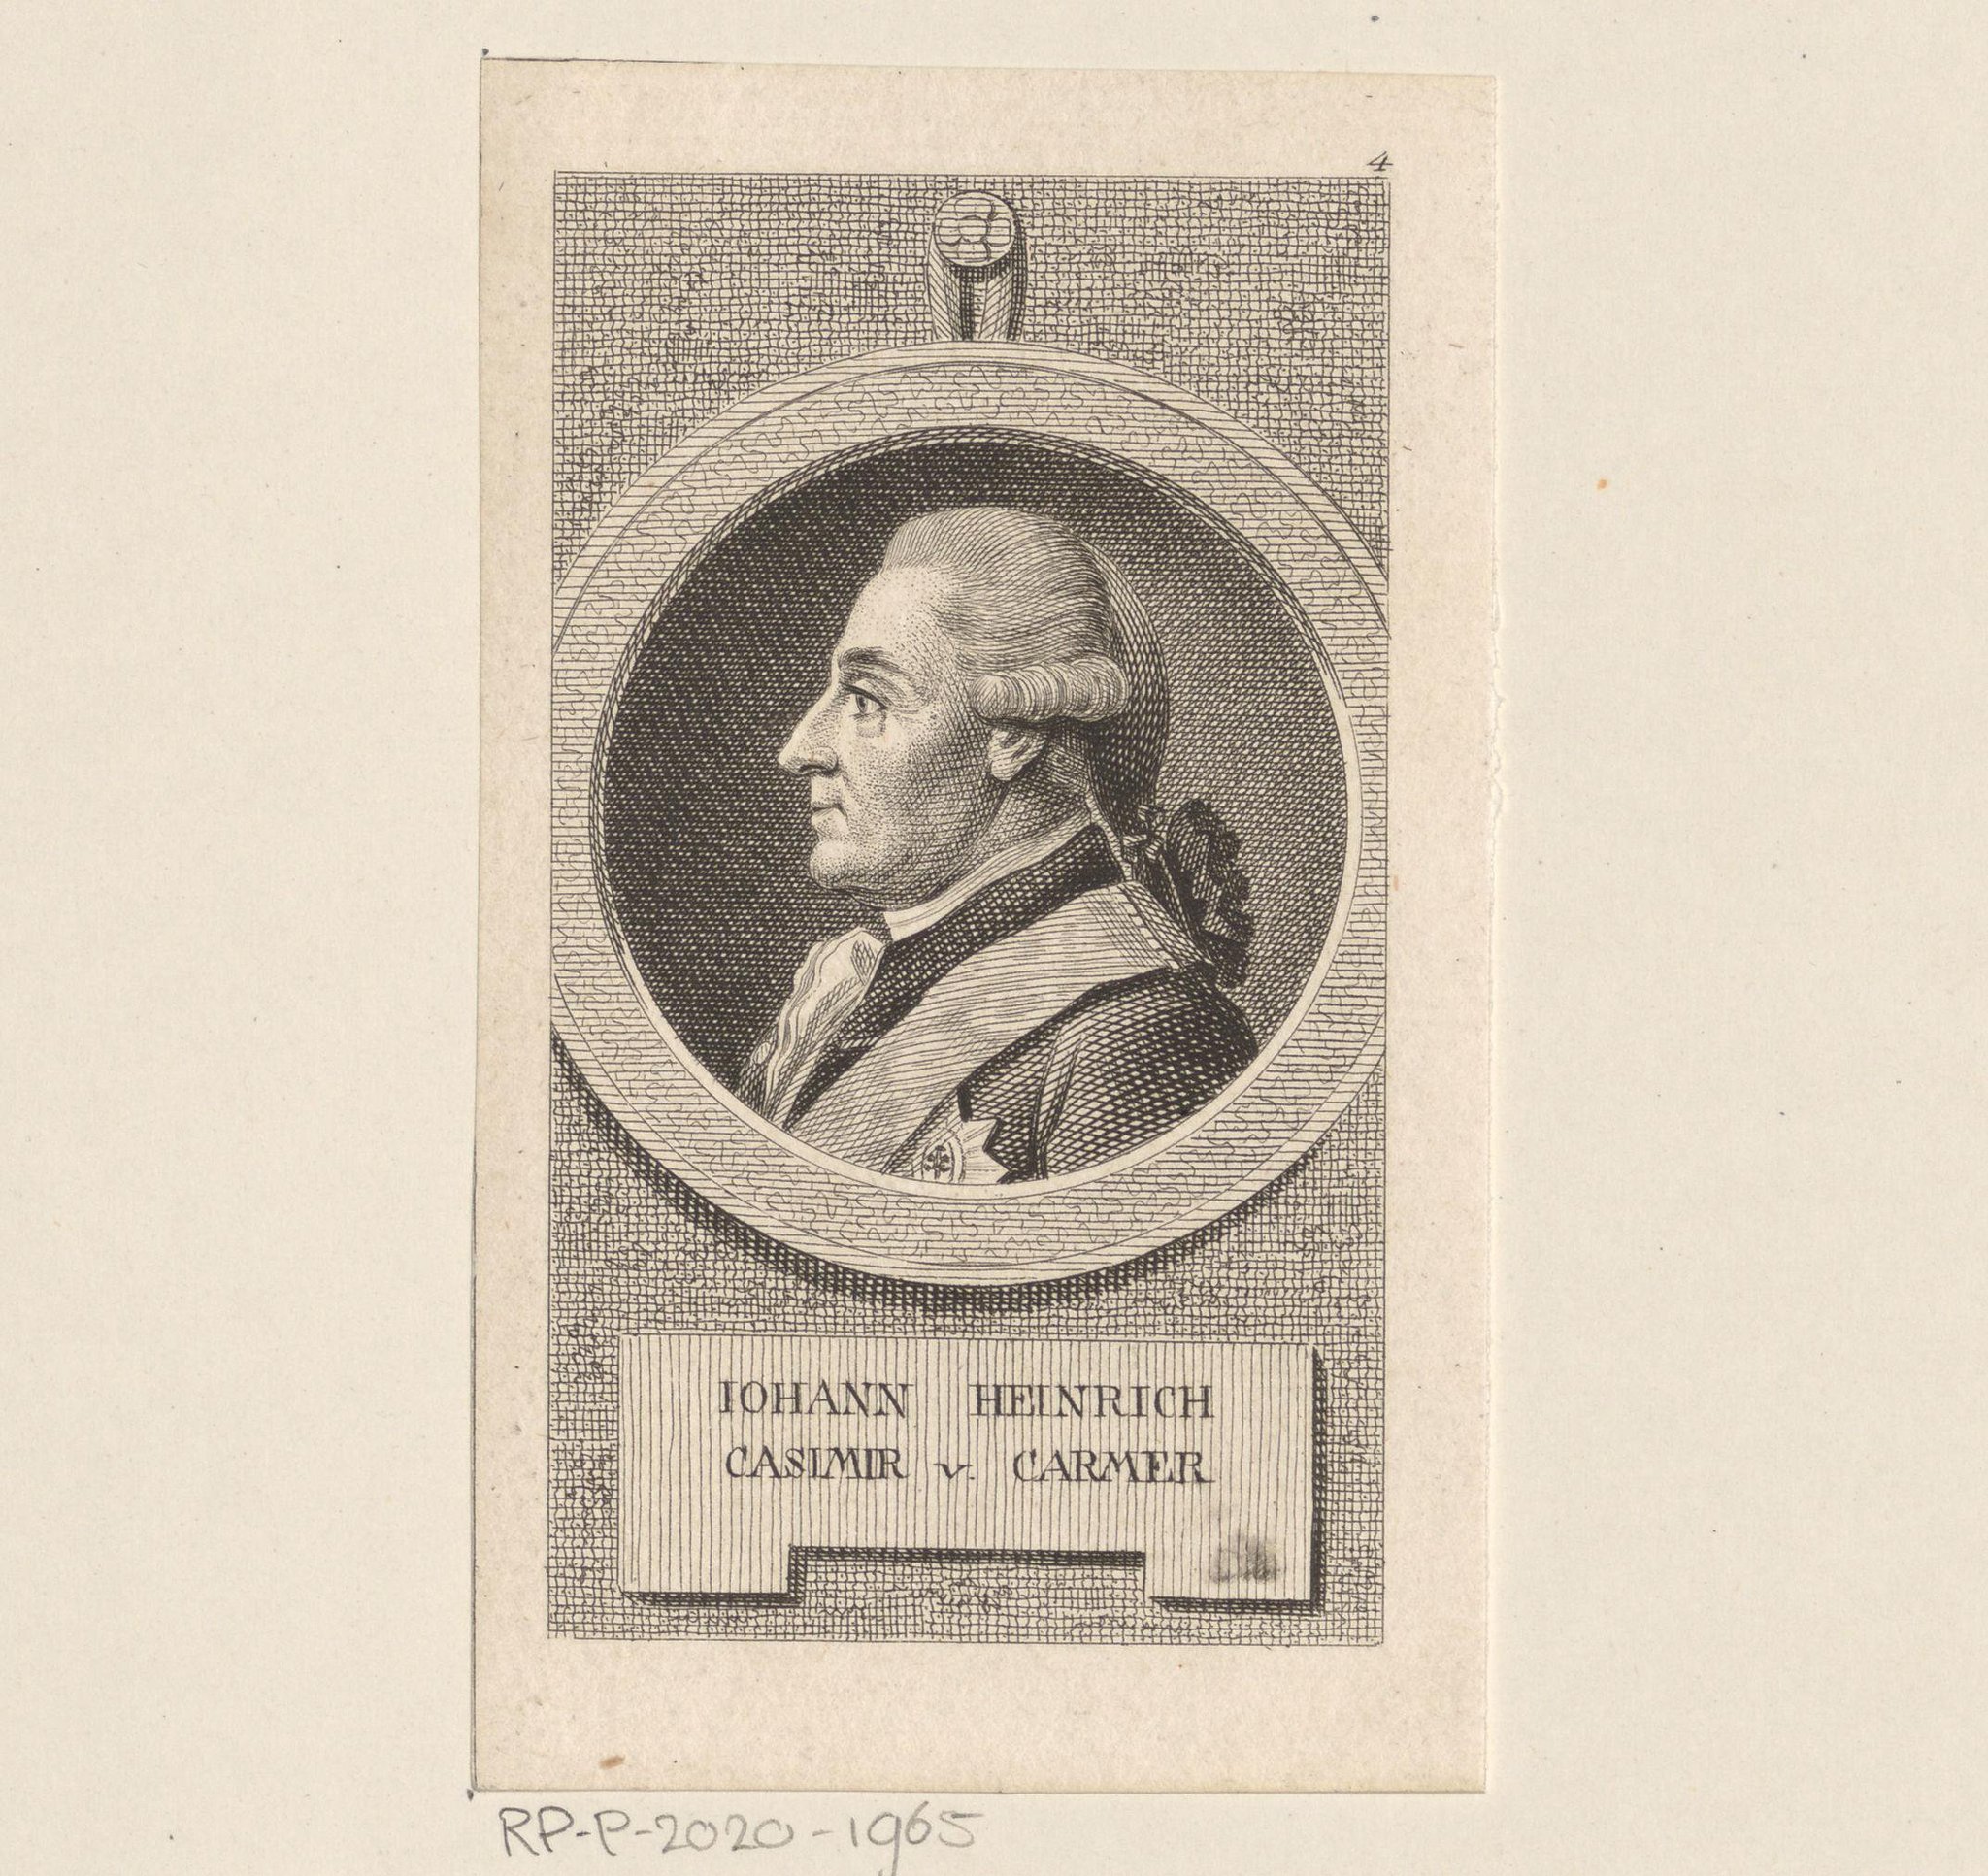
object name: print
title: Portret van Johann Heinrich Casimir Carmer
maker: Anonymous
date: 1750-1849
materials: paper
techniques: engraving, etching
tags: historical persons